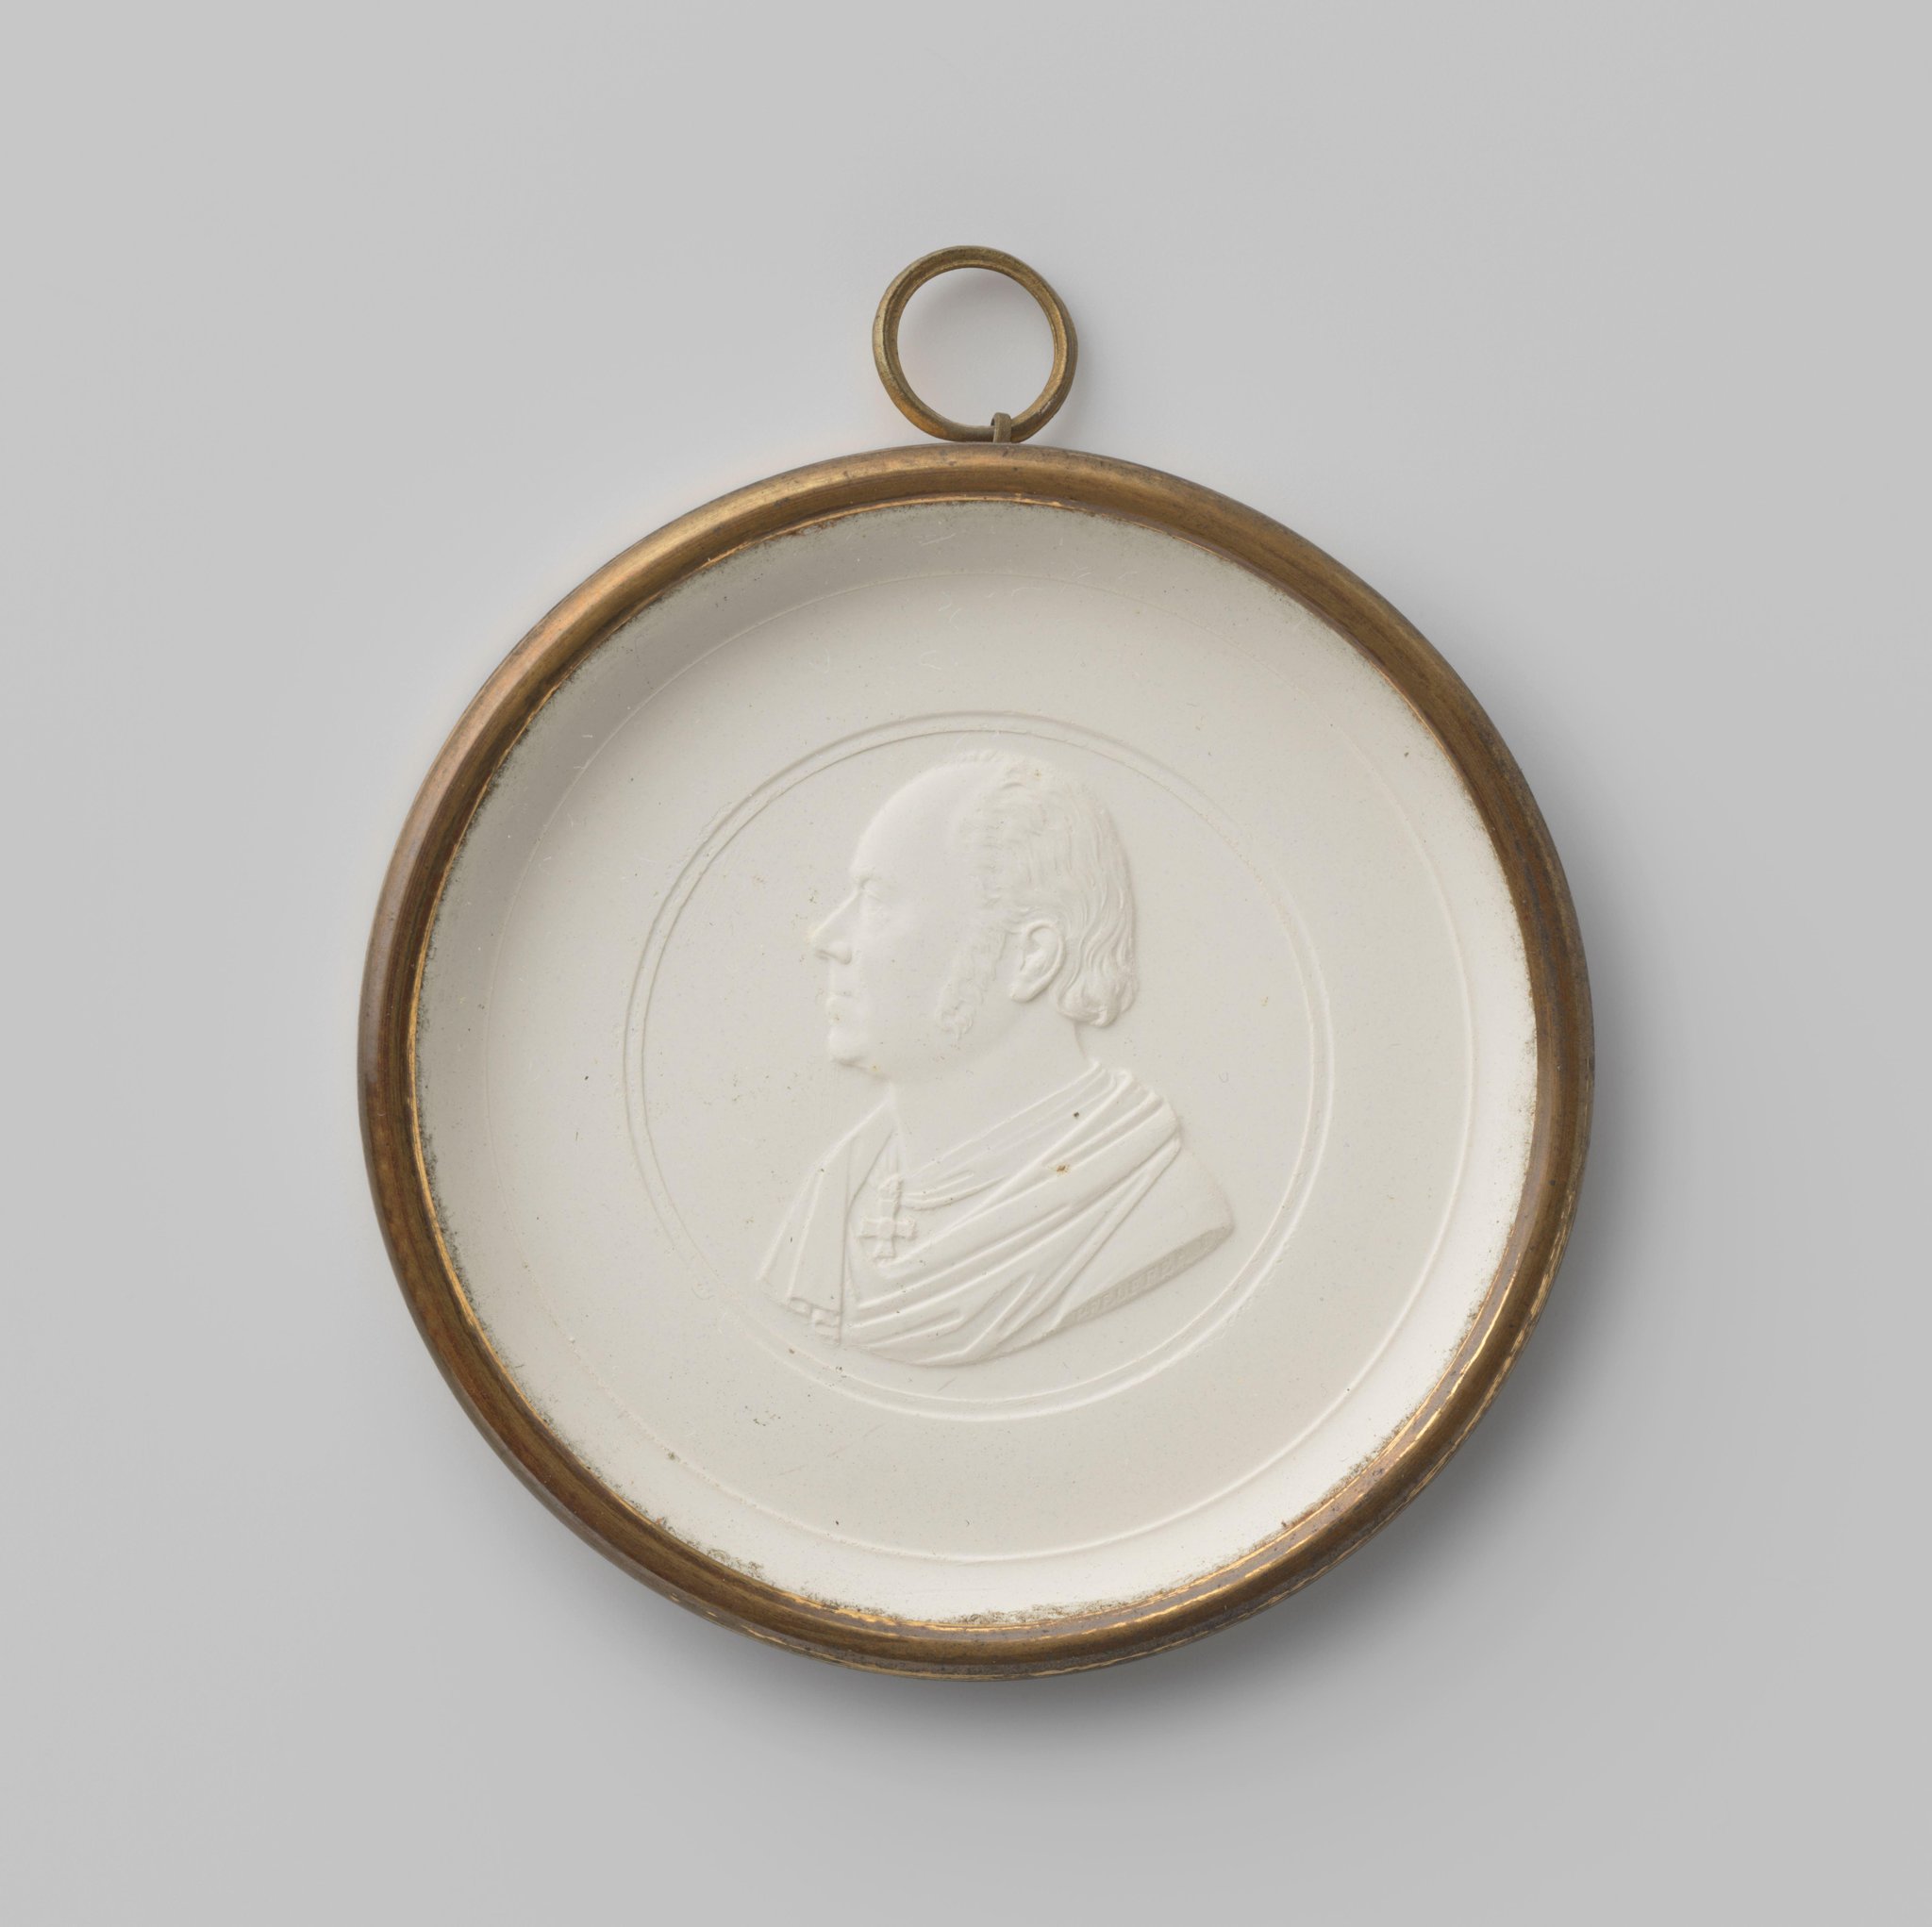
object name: locket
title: Niemeyer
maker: gottfried eichler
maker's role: draughtsman, painter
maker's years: 1677-1757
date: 1687-1757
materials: brass, glass, gypsum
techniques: casting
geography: berlin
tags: niemeyer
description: Eenzijdig medaillon in messing ring achter glas aan draagoog en draagring. Voorzijde: borststuk man naar links. Keerzijde: etiket met opschrift.